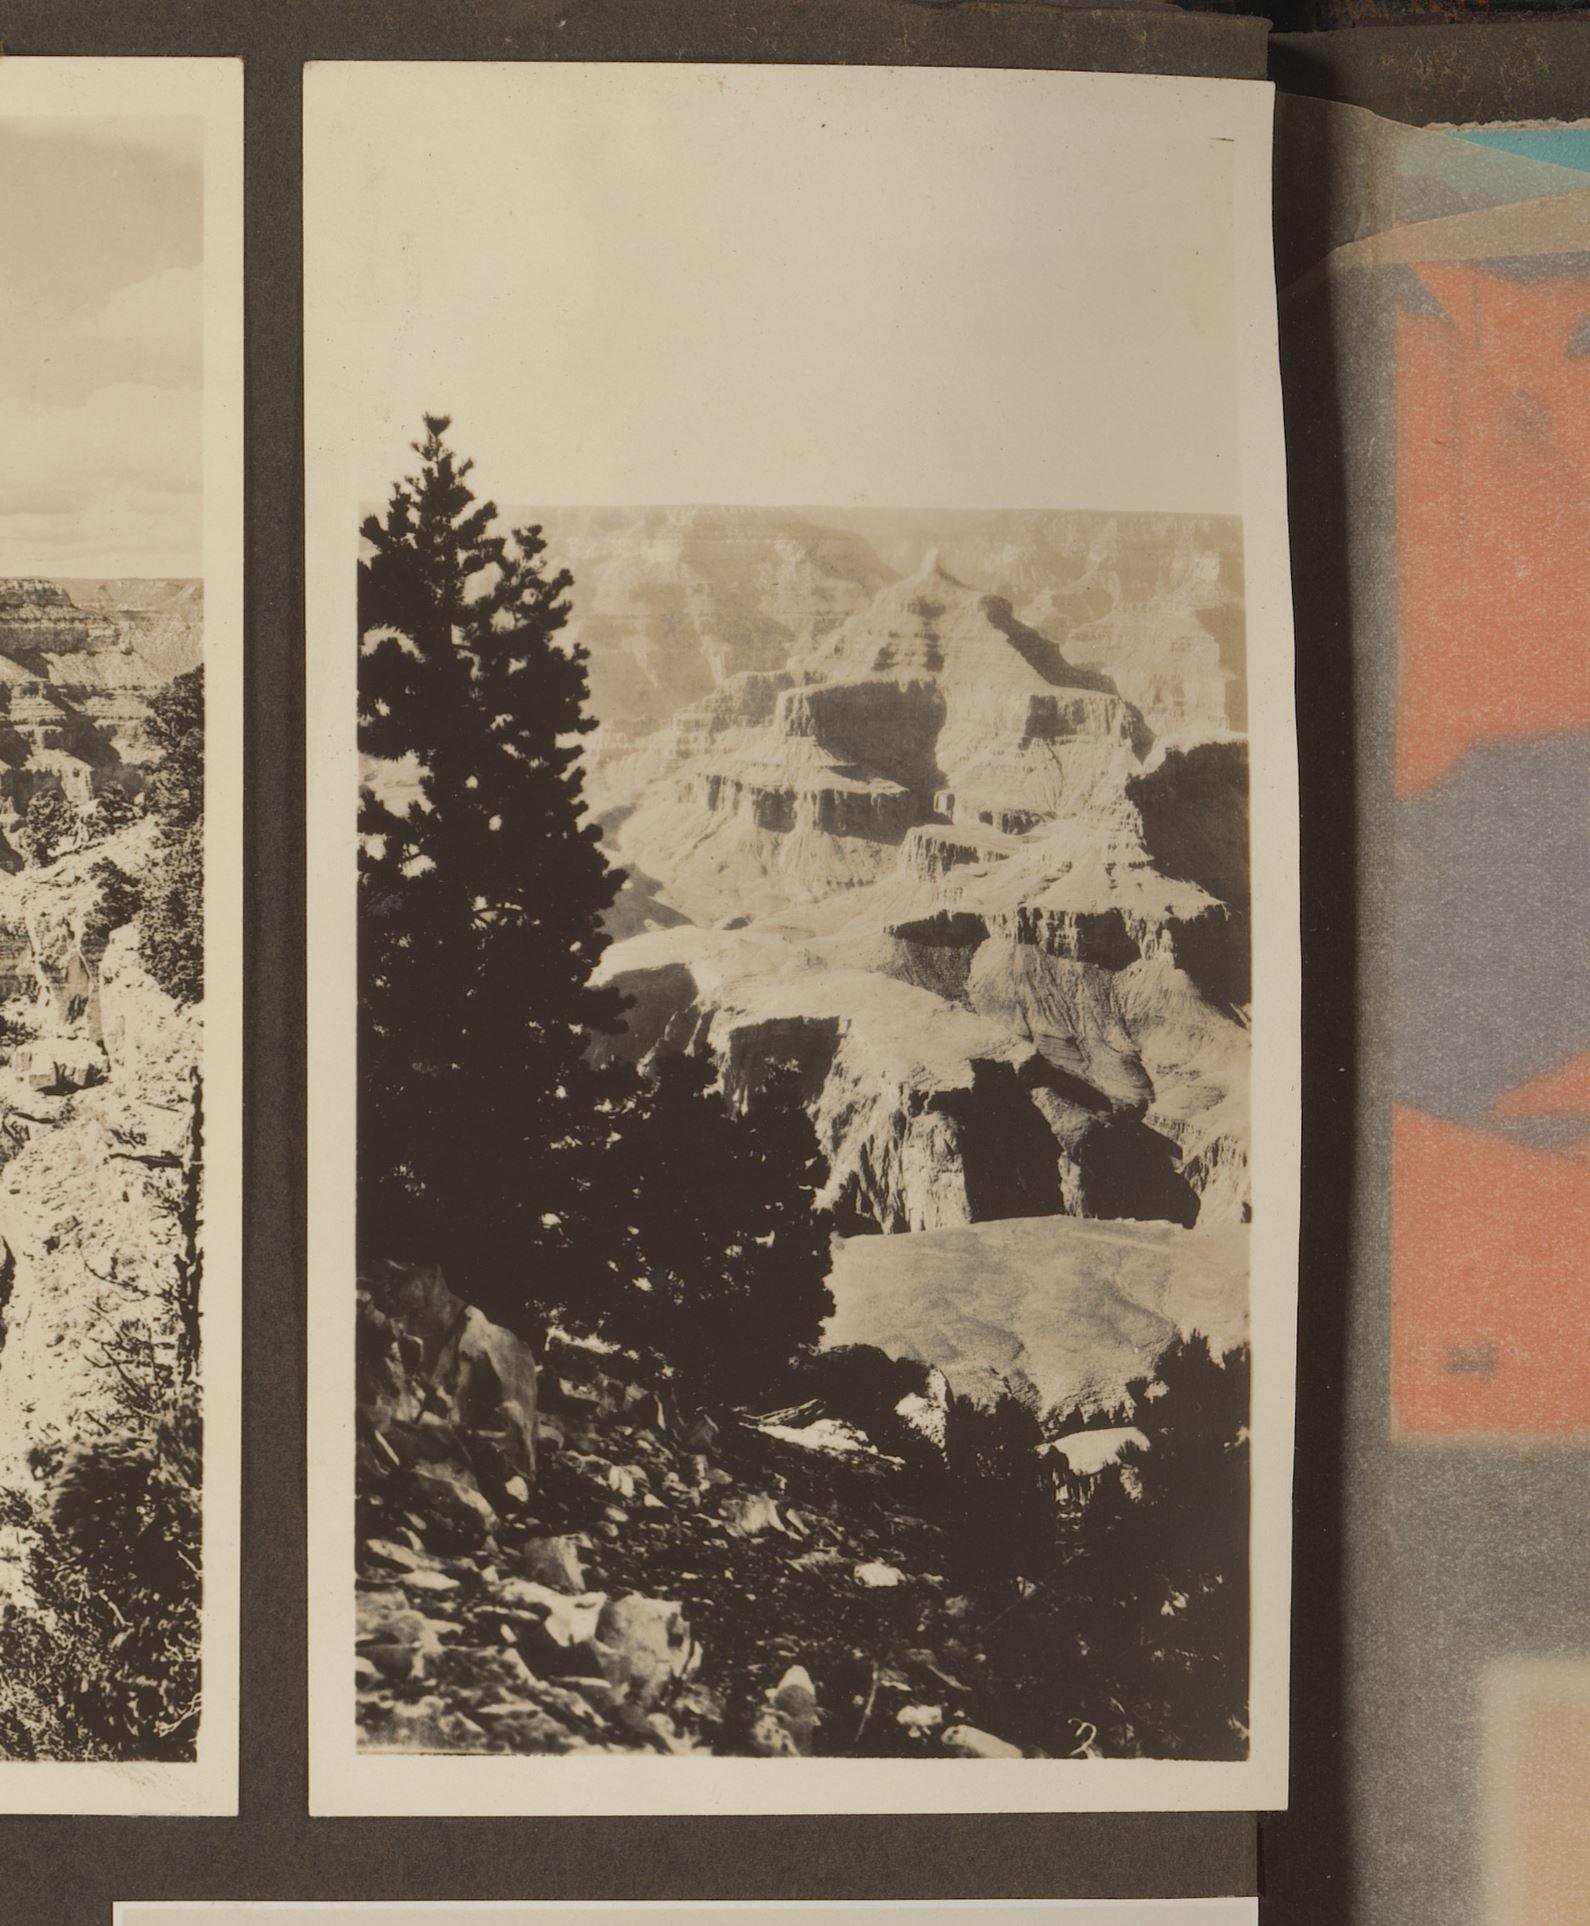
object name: photograph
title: Gezicht op de Grand Canyon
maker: Anonymous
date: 1928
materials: photographic support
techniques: gelatin silver print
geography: grand canyon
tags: ravine, chasm, abyss, canyon, mountains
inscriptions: annotation: ‘Grand Canyon’